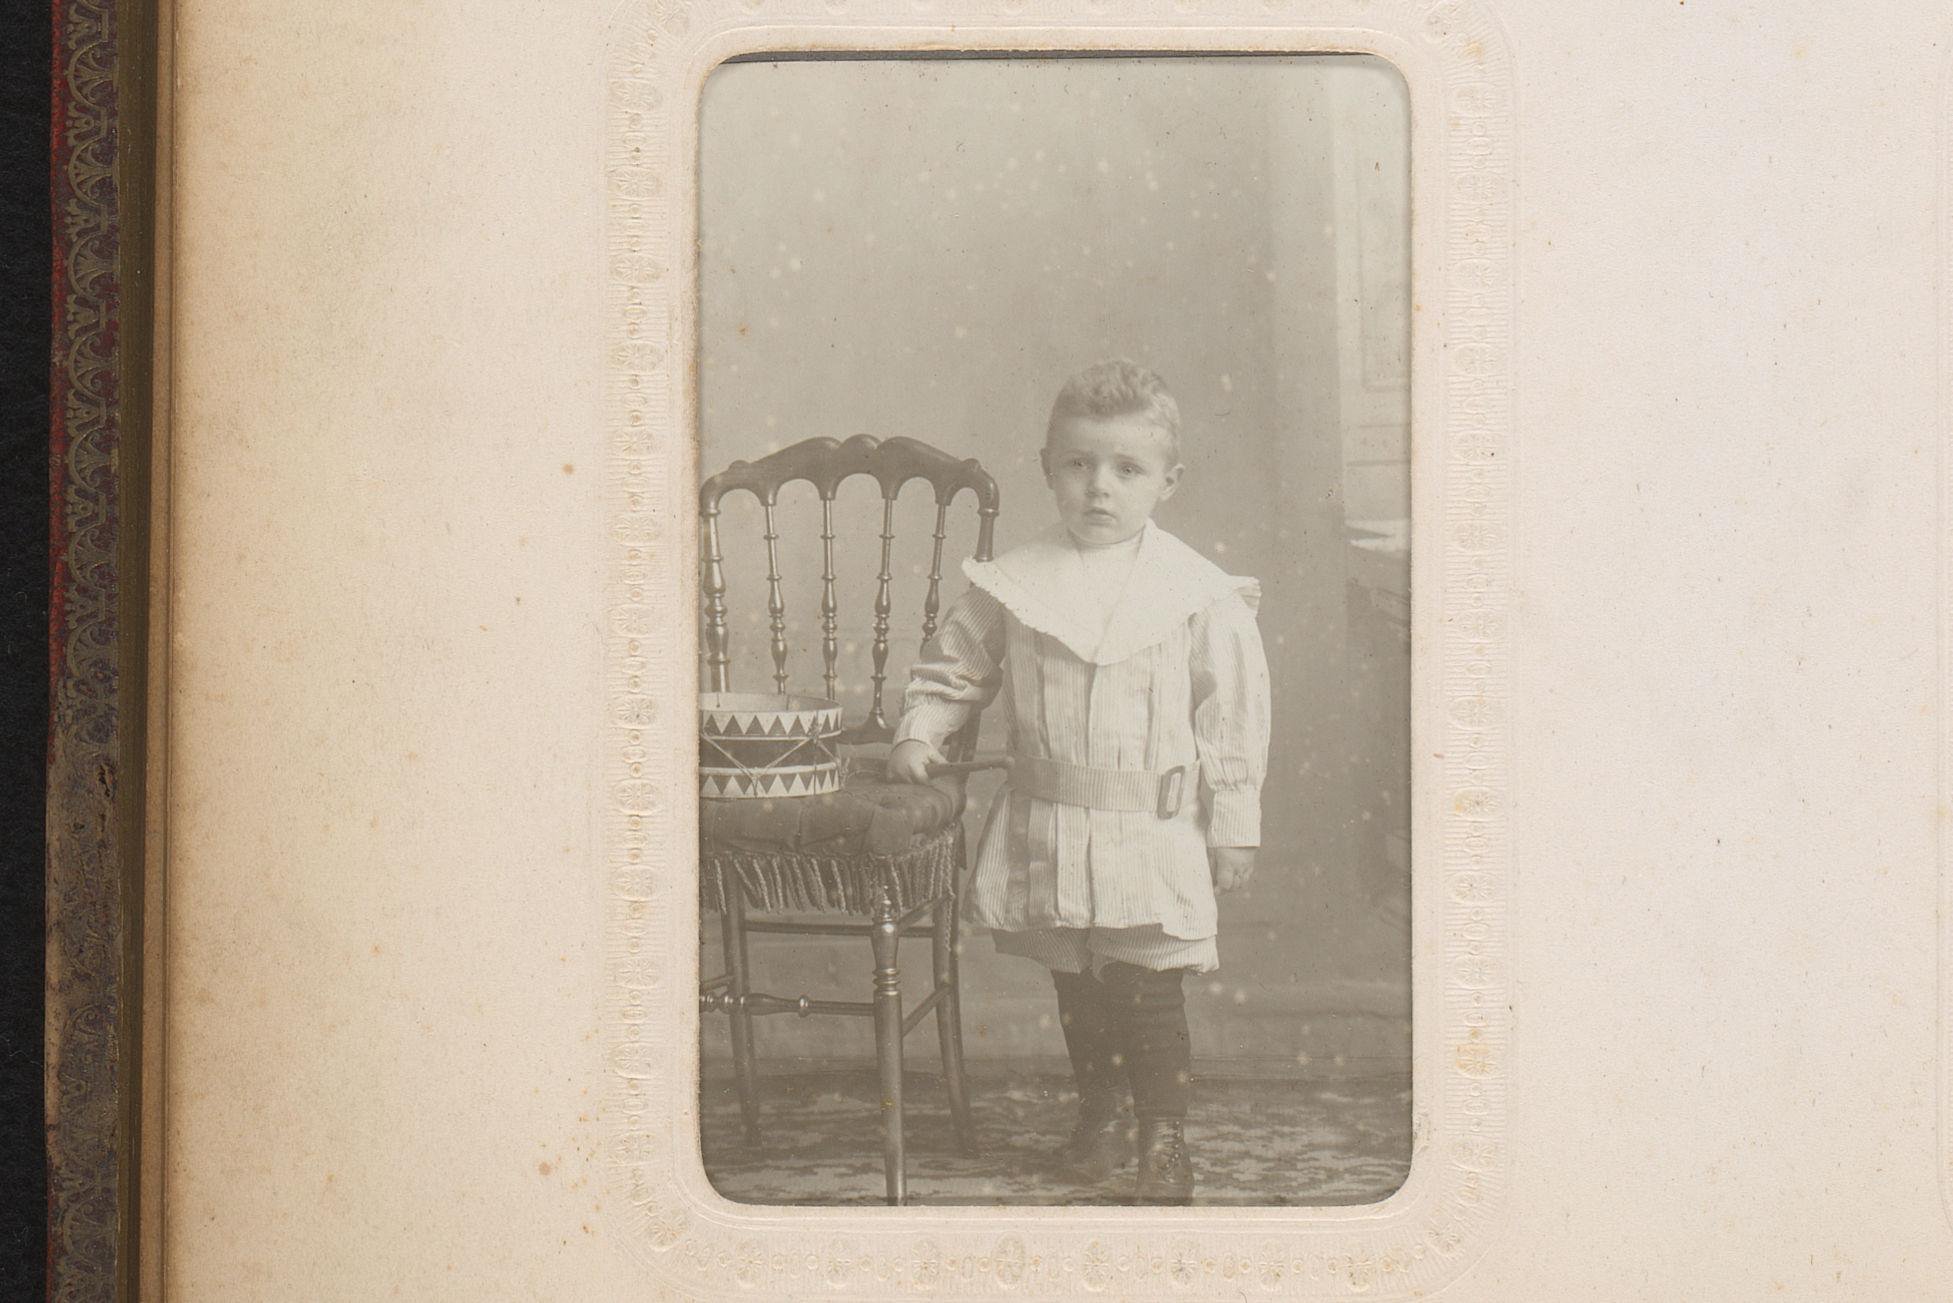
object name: album leaf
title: Portret van een meisje, staand voor een balustrade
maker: Anonymous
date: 1880-1920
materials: cardboard, photographic support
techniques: daylight paper print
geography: netherlands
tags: historical persons - bb - woman, balustrade, toddler (female), standing figure - aa - female human figure